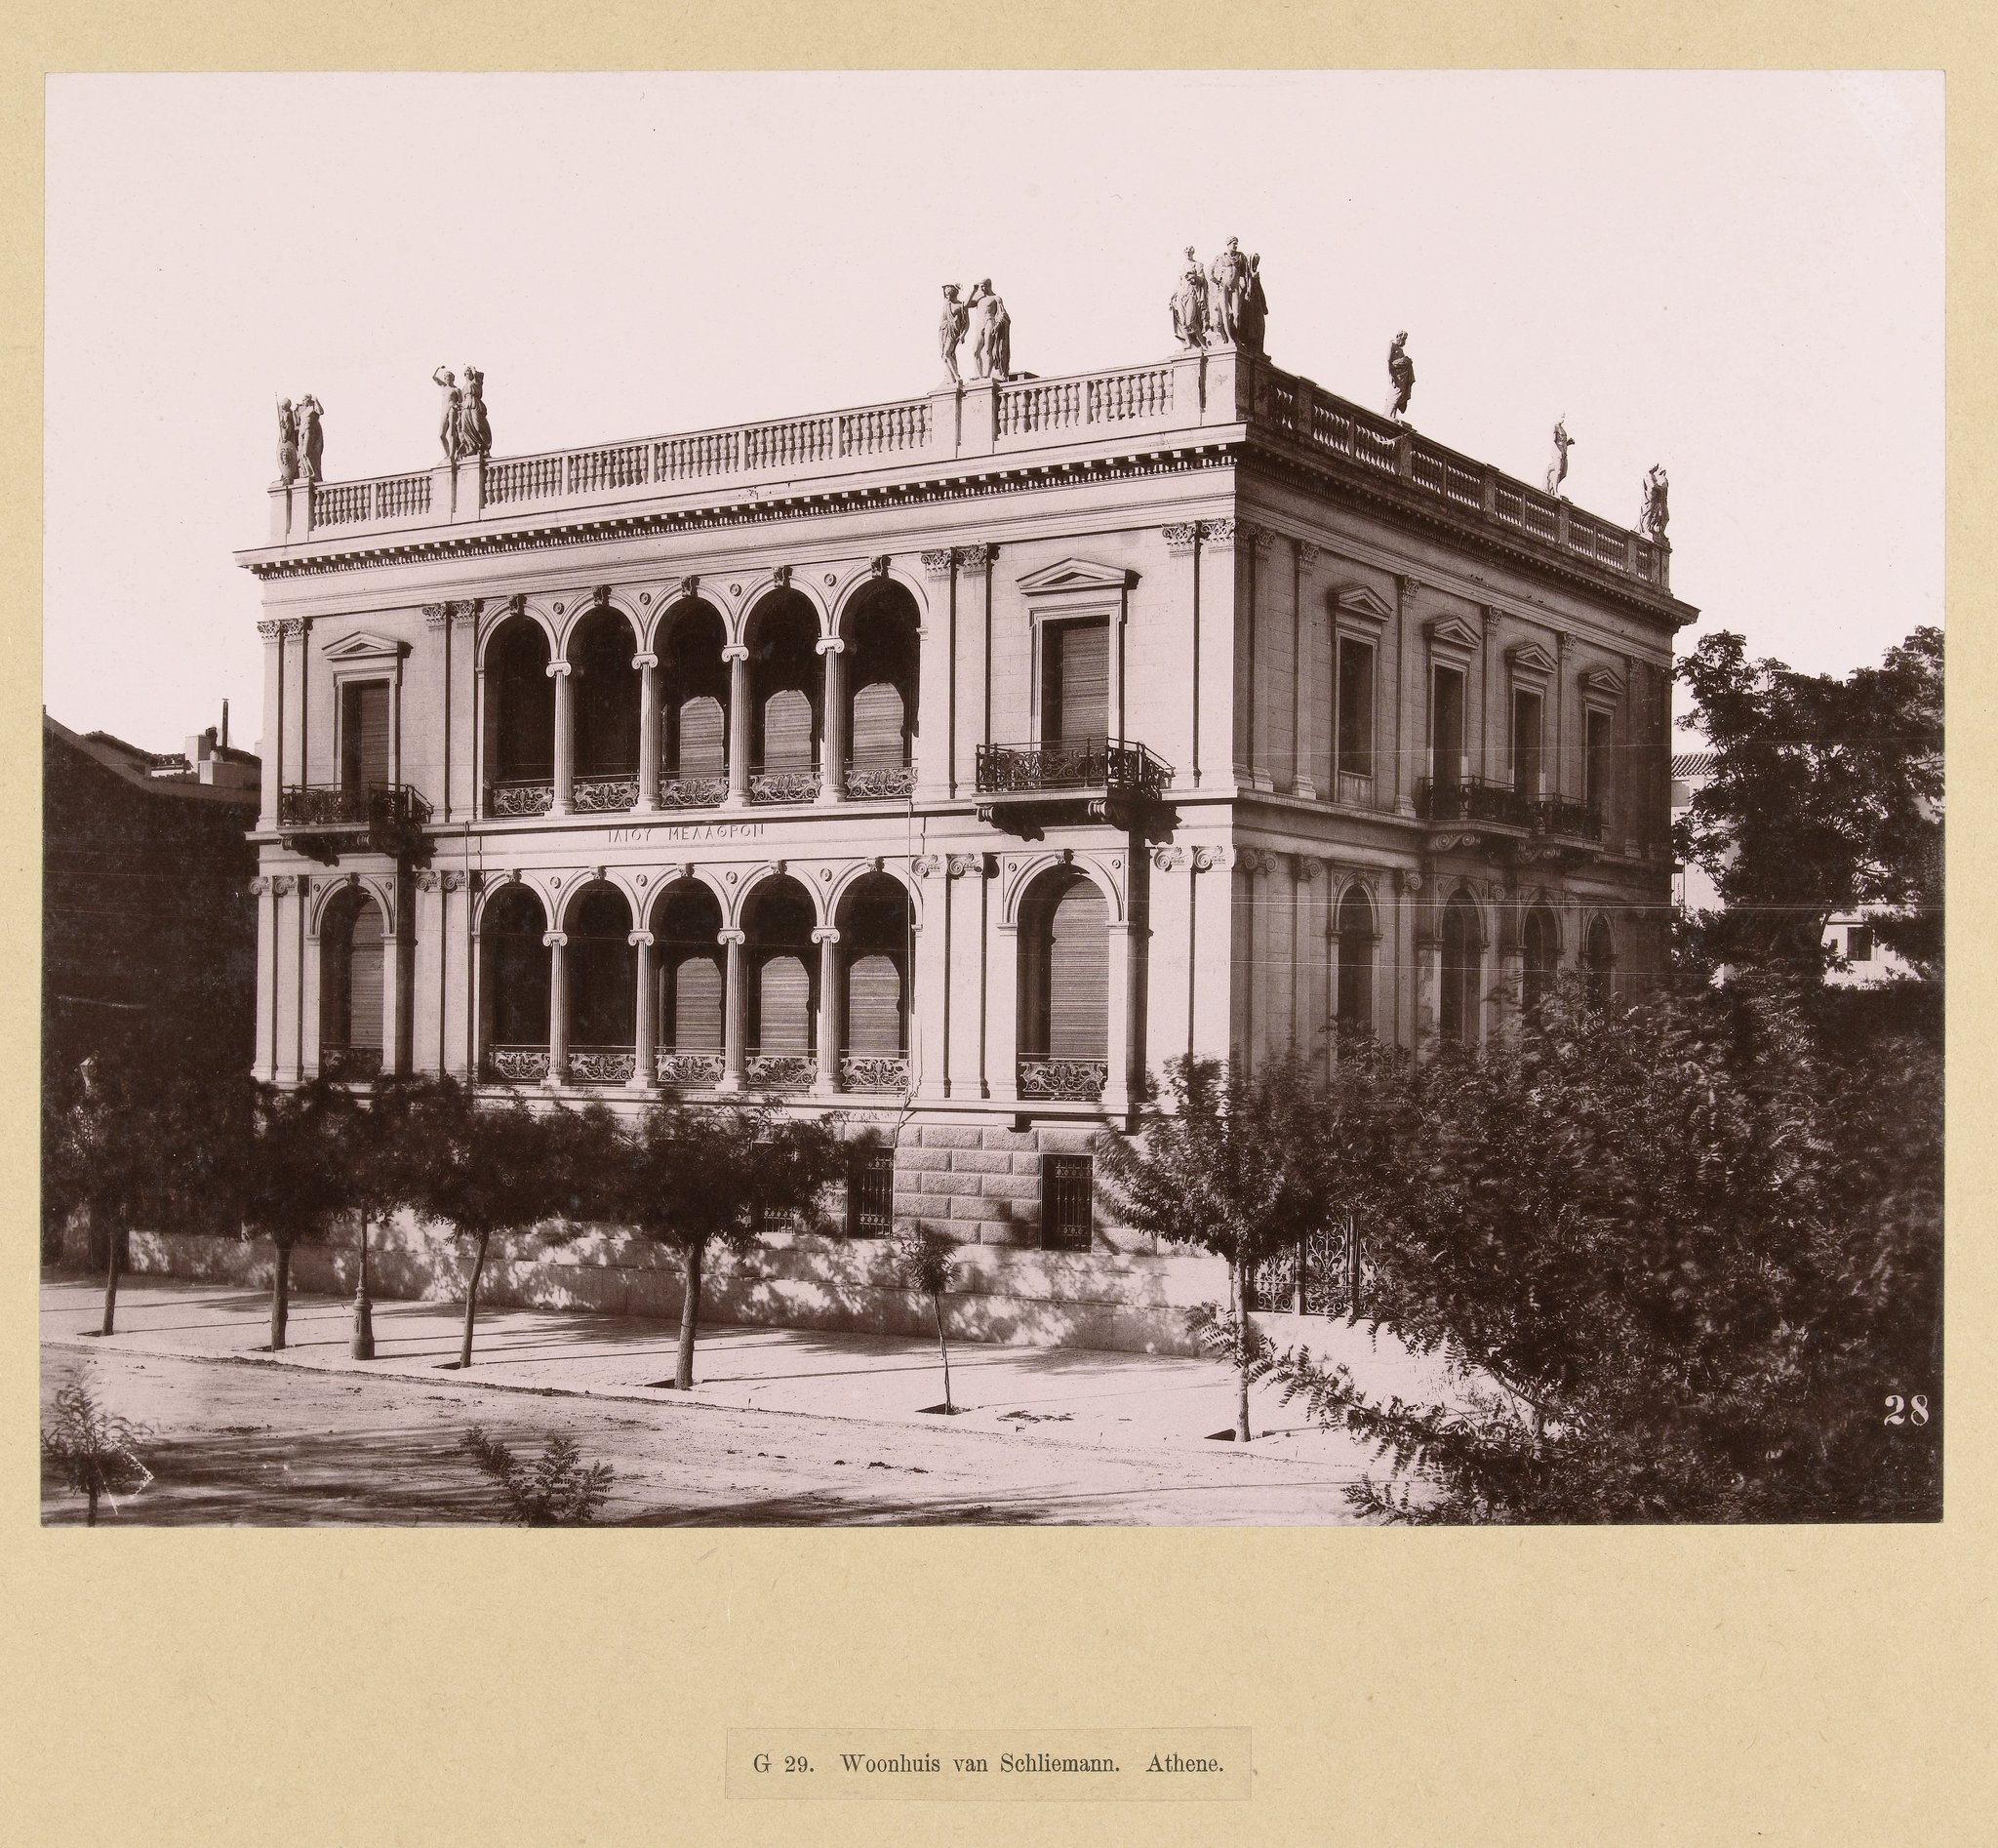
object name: photomechanical print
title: Huis van archeoloog Heinrich Schliemann in Athene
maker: Anonymous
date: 1890-1895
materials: cardboard, paper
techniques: photograph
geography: athens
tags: villa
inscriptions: title: ‘G 29. Woonhuis van Schliemann. Athene.’, check stamp: ‘Bristol/ L.M.’, stamp: ‘Gemeentelijke bibliotheek/ Rotterdam’, number: ‘28’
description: Onderdeel van een groep door fotograaf Richard Polak op reis verzamelde foto’s. Deze fotomechanische afdruk is samen met andere op zijn reizen verzamelde foto's tentoongesteld bij de Rotterdamsche Kunstkring (1895), Arti en Amicitiae te Amsterdam (1897-1898?) en Societeit 't Collegie te Kampen (datum vooralsnog onbekend).